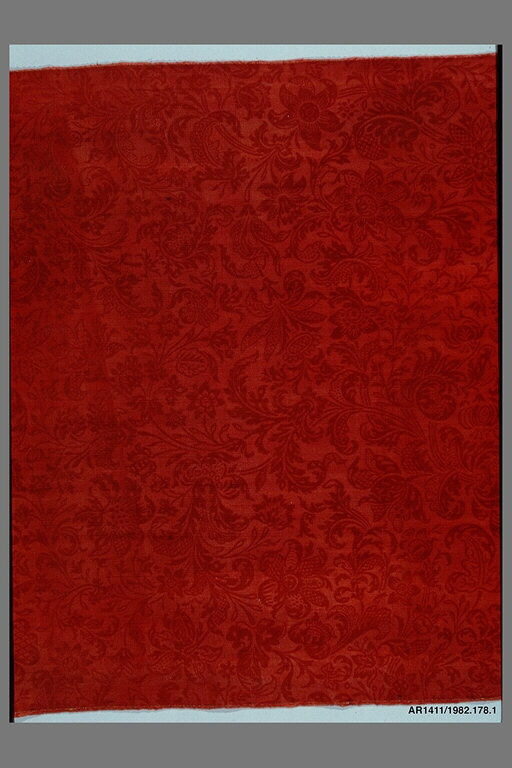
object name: length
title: Panel of printed camlet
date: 1690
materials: wool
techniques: weave, printing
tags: flowers